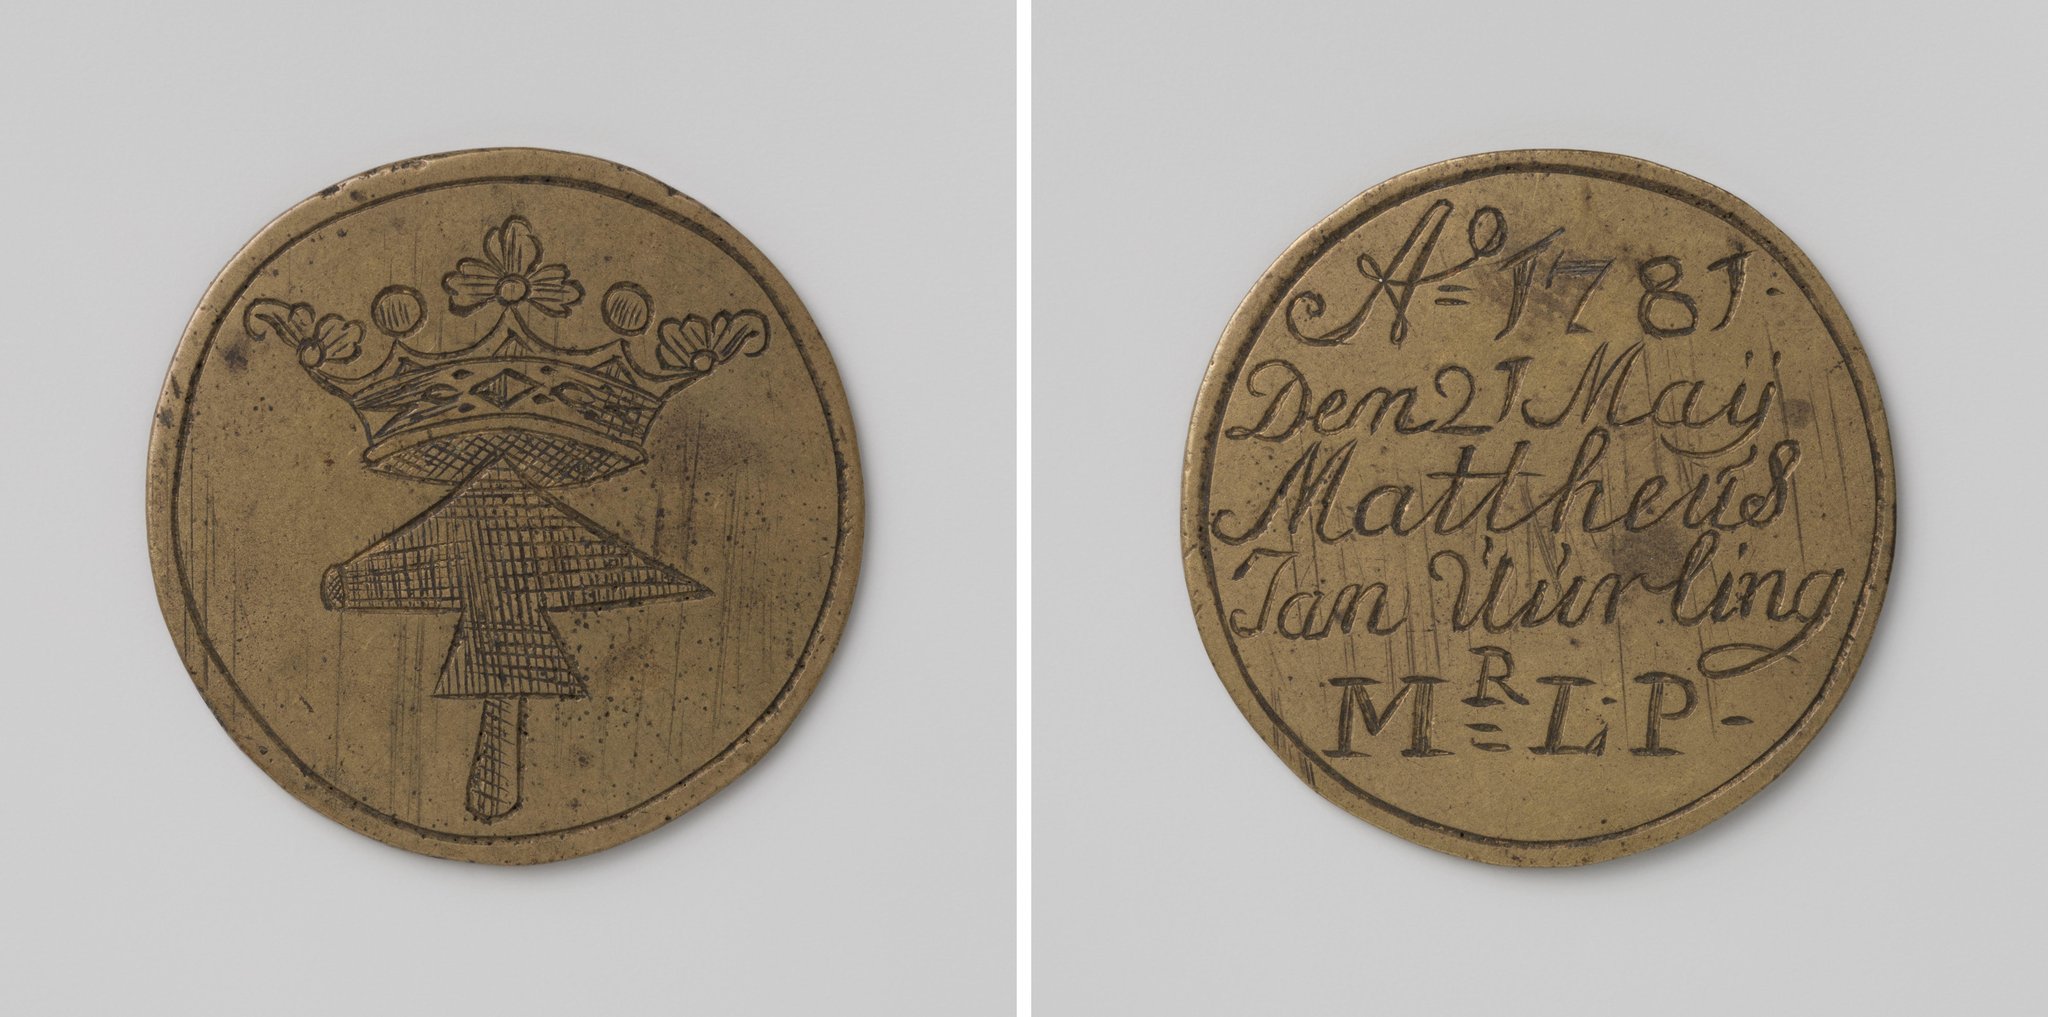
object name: medal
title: Metselaars-, steenhouwers-, leidekkers-, loodgieters- en pompenmakersgilde van Amsterdam, gildepenning van Mattheus Jan Uurling, meester loodgieter en pompmaker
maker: Anonymous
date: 1781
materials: brass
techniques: engraving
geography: amsterdam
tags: amsterdam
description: Messing penning. Voorzijde: gekroonde loodgietershamer. Keerzijde: opschrift